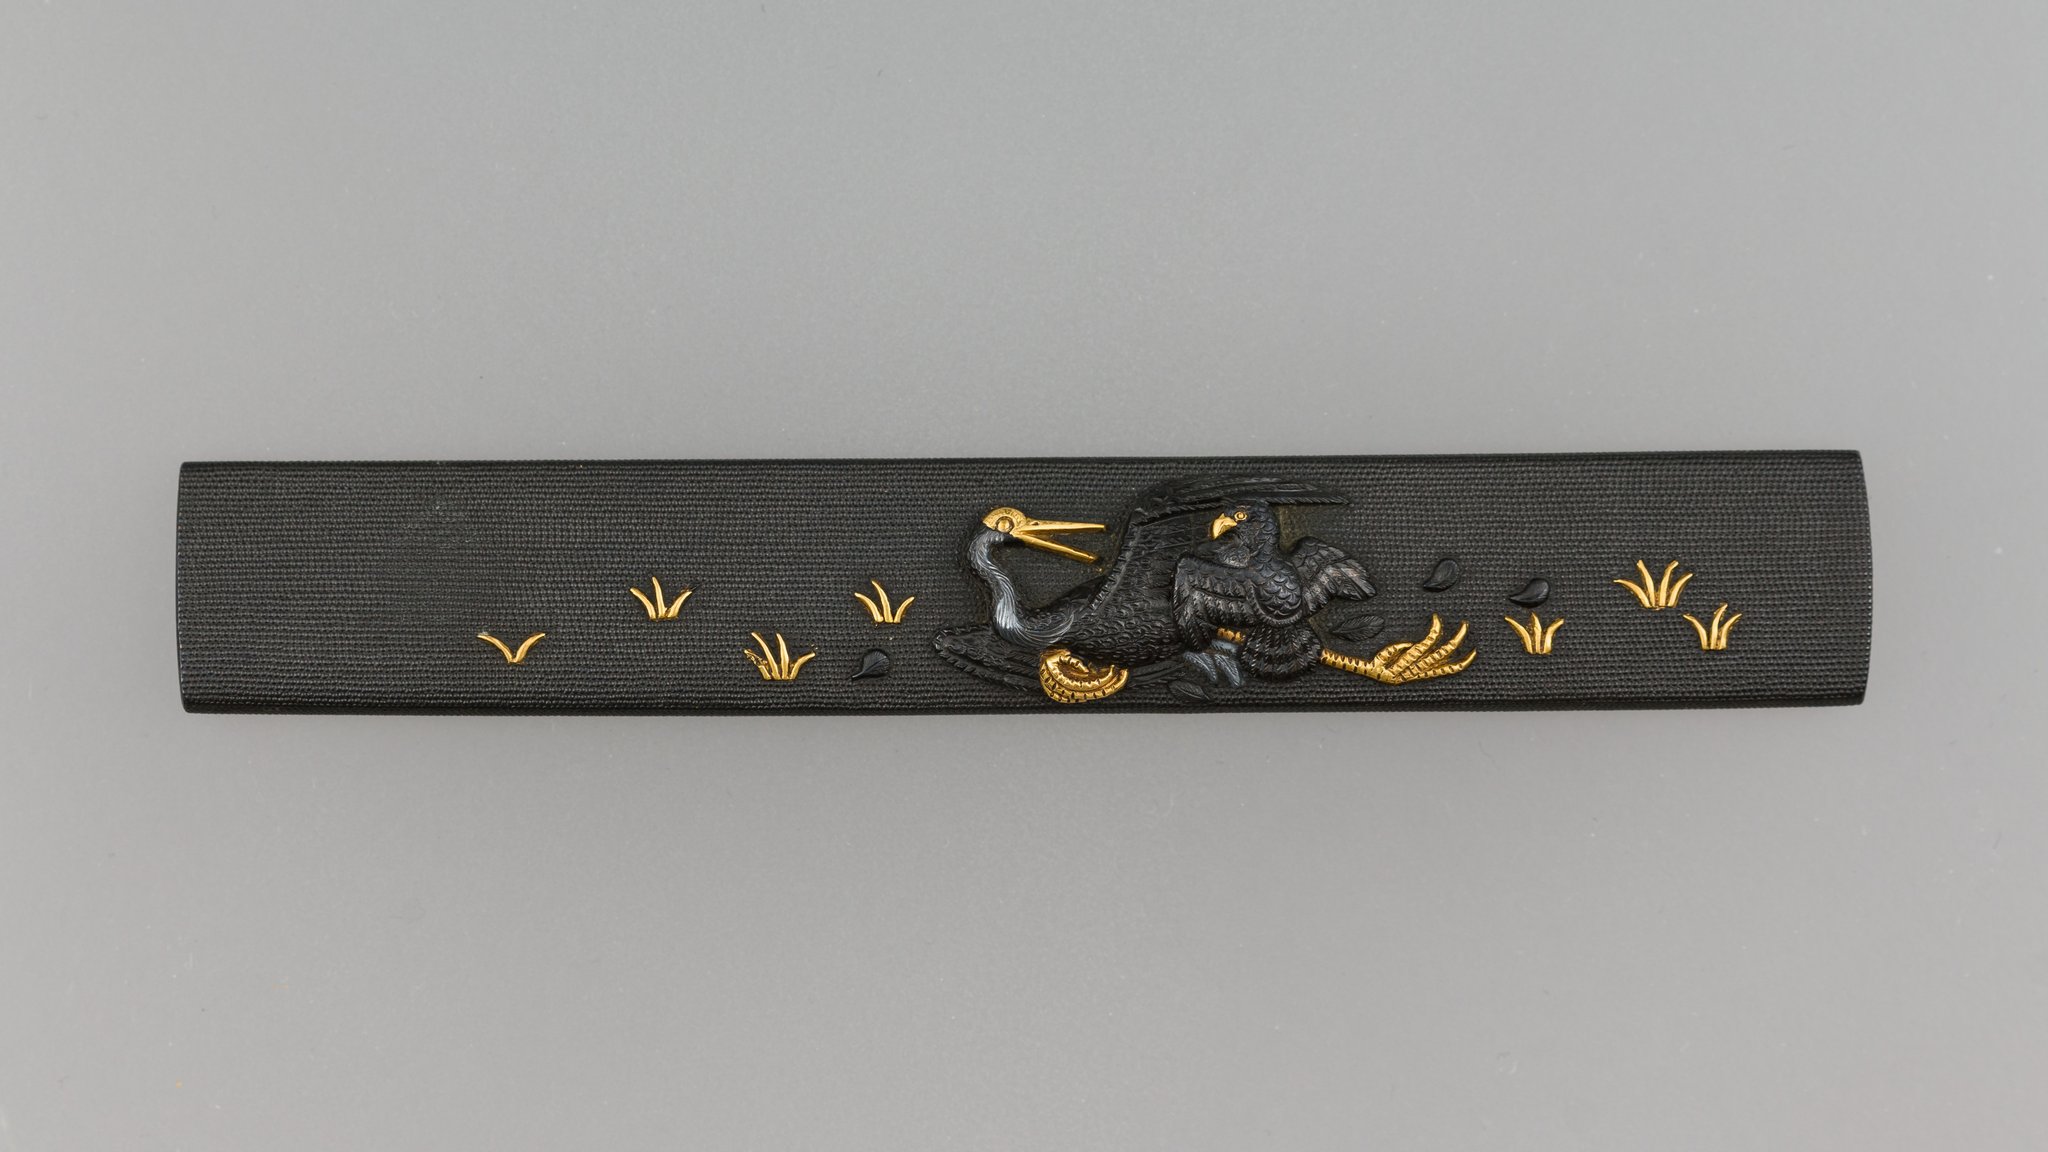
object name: knife handle kozuka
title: Knife Handle (Kozuka)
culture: japanese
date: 1816-1856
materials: gold alloy, gold, silver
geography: japan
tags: cranes